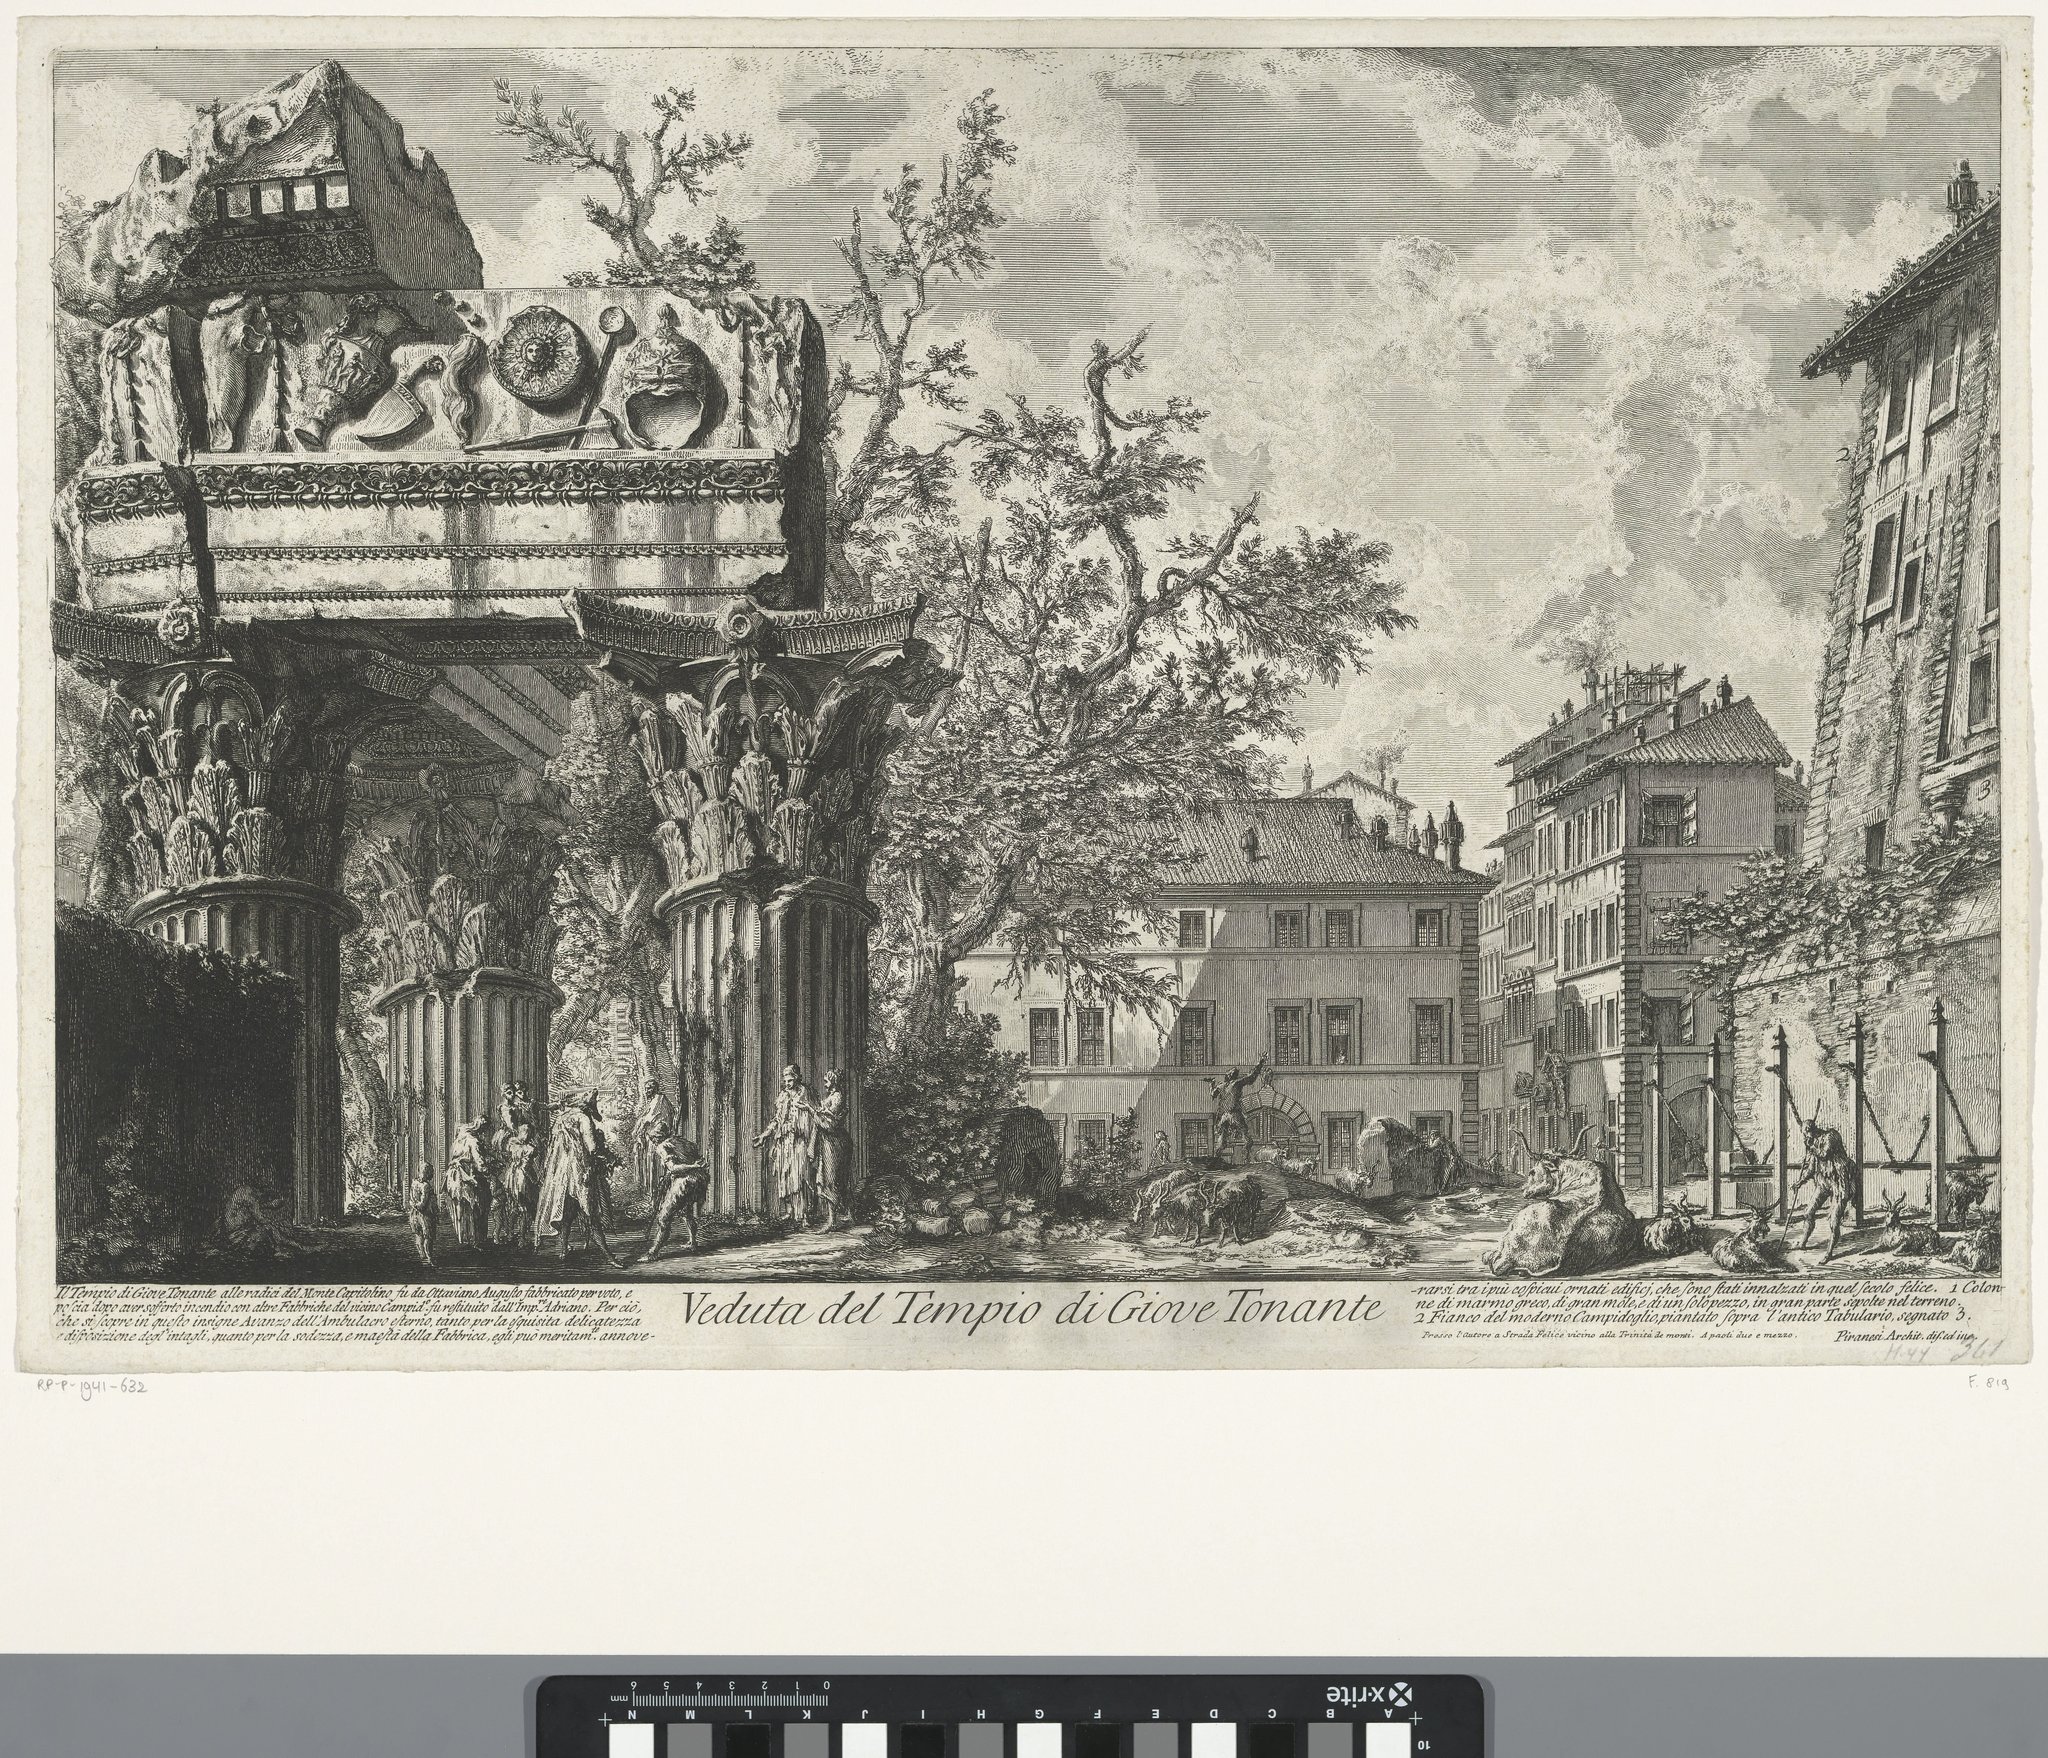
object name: print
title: Veduta del Tempio di Giove Tonante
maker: giovanni battista piranesi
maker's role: designer, draughtsman, print maker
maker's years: 1720-1778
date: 1748-1778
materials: paper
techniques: etching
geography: rome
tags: ruin of a building ~ architecture, landscape with ruins, temple, shrine ~ roman religion, rome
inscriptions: collector's mark: Lugt 2228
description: Deze prent maakt deel uit van de serie 'Vedute di Roma'. Piranesi werkte aan deze 135 platen tellende serie tussen 1748 en zijn dood in 1778. Francesco Piranesi voegde later nog twee prenten toe aan de reeks van zijn vader.